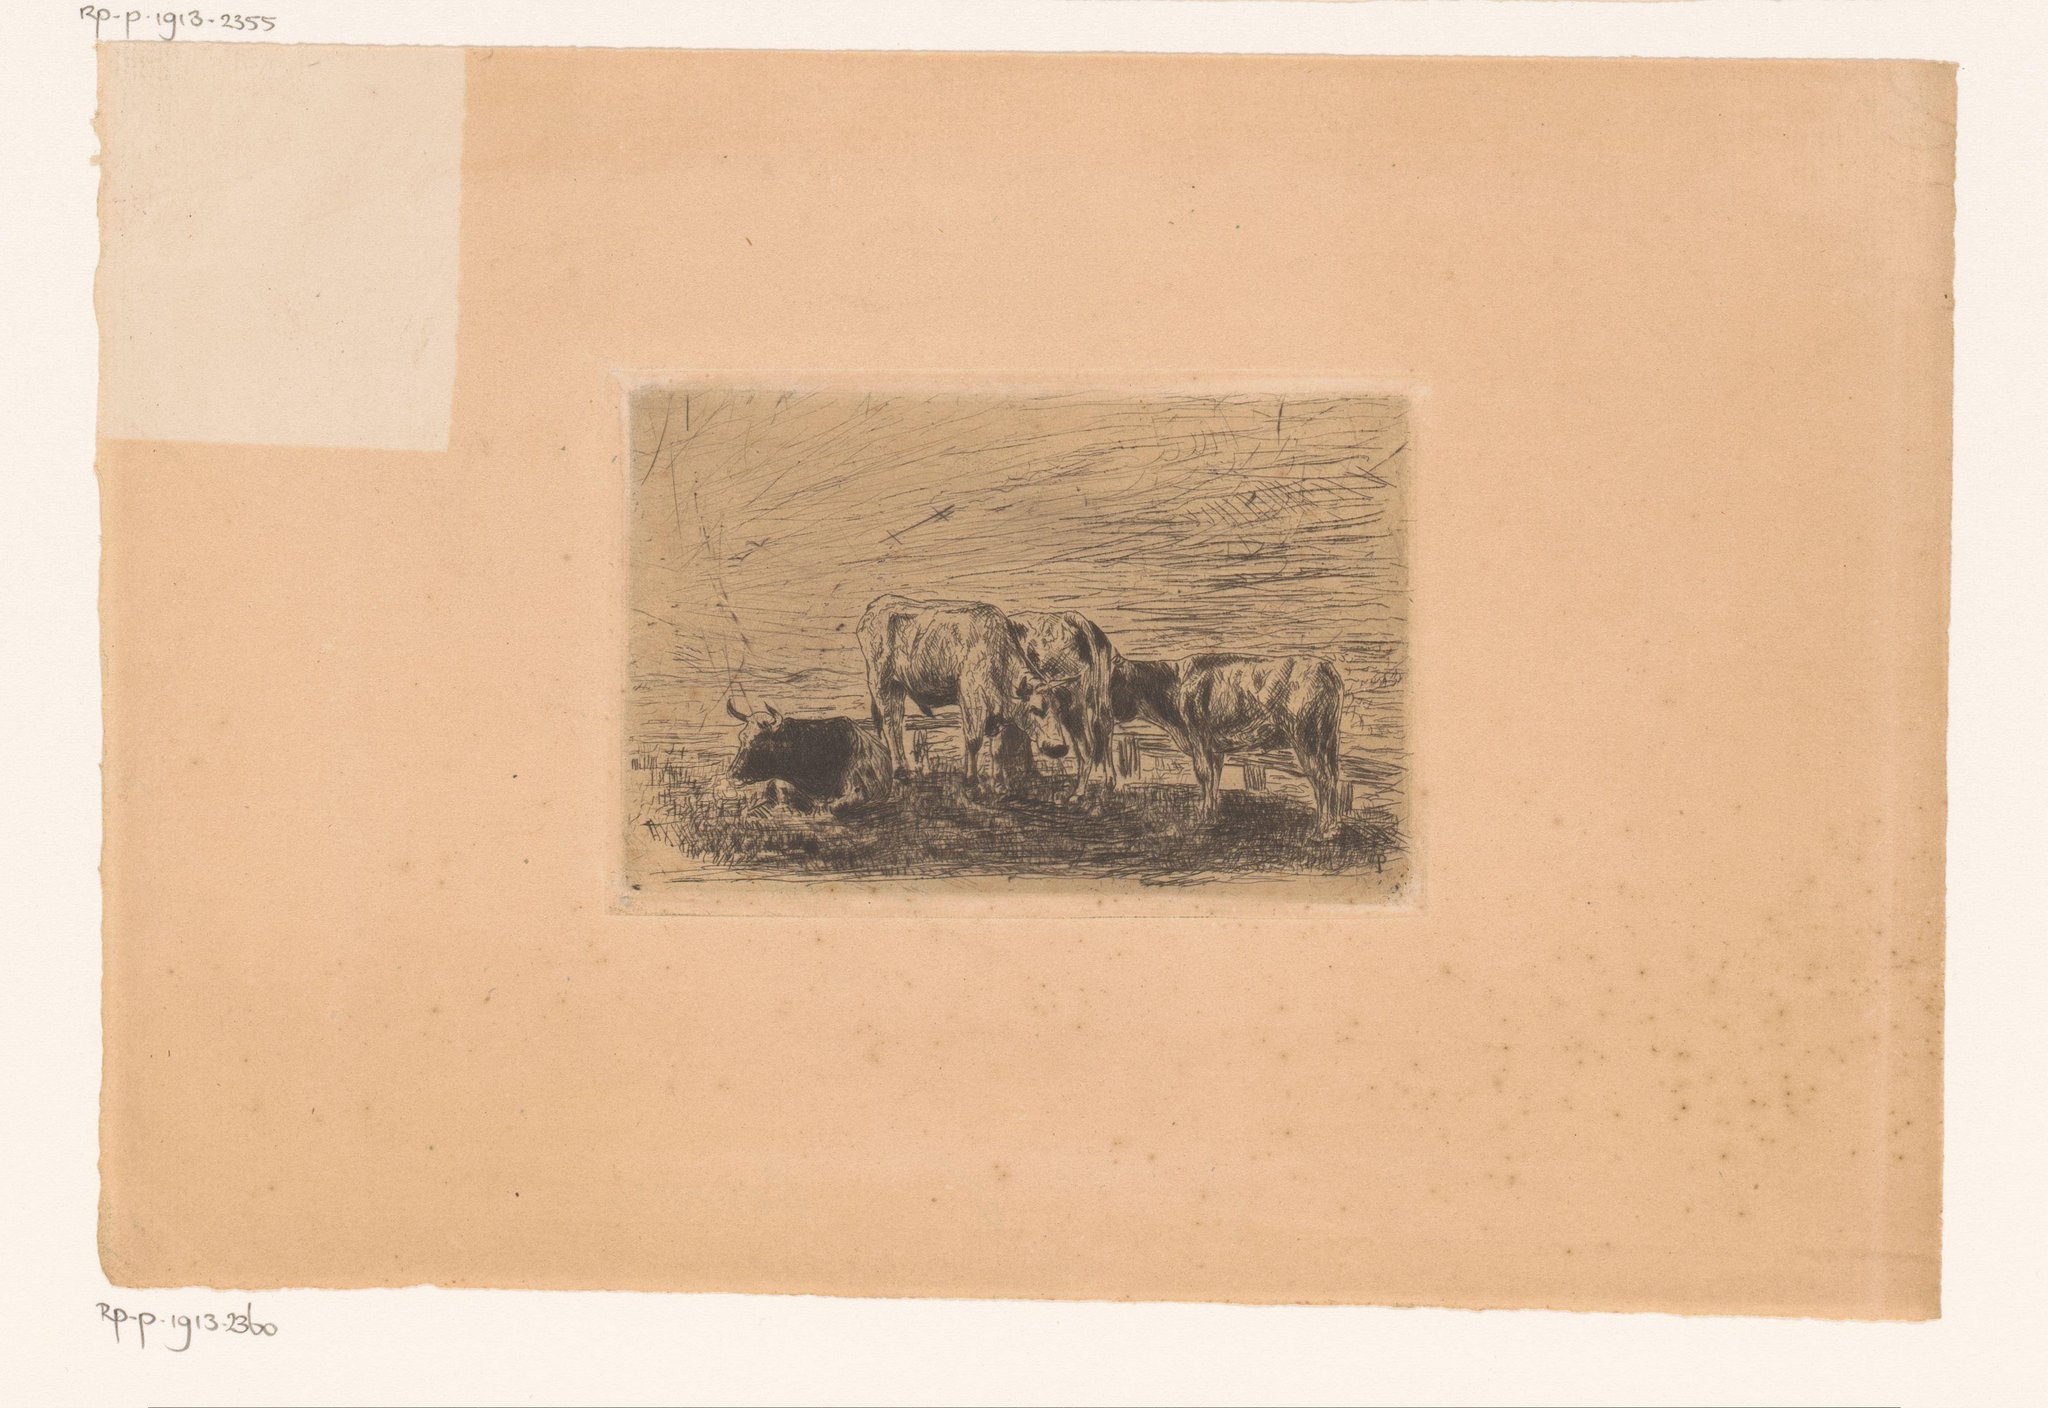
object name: print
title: Vier runderen in de wei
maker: paul parmentier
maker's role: print maker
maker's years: 1854-1902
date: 1864-1902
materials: paper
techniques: etching, intaglio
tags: bovine cattle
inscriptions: collector's mark: Lugt 2228